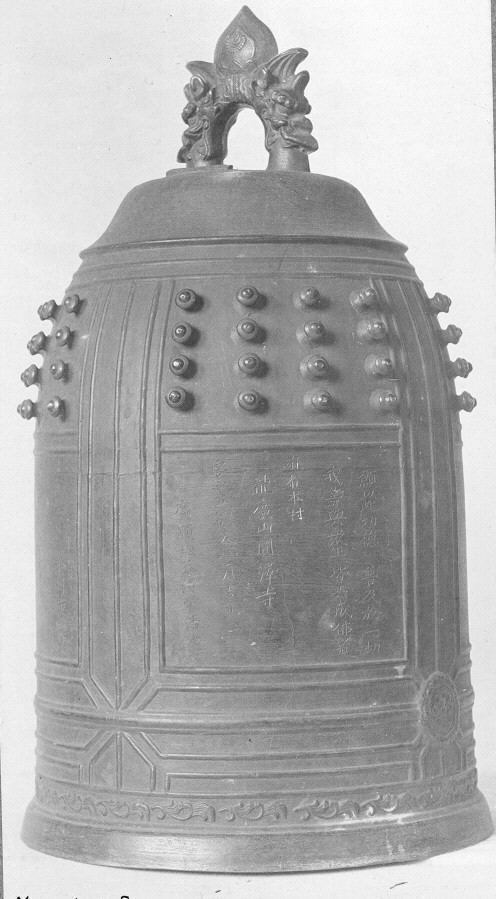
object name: densho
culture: japanese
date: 1767-1800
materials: bronze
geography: japan